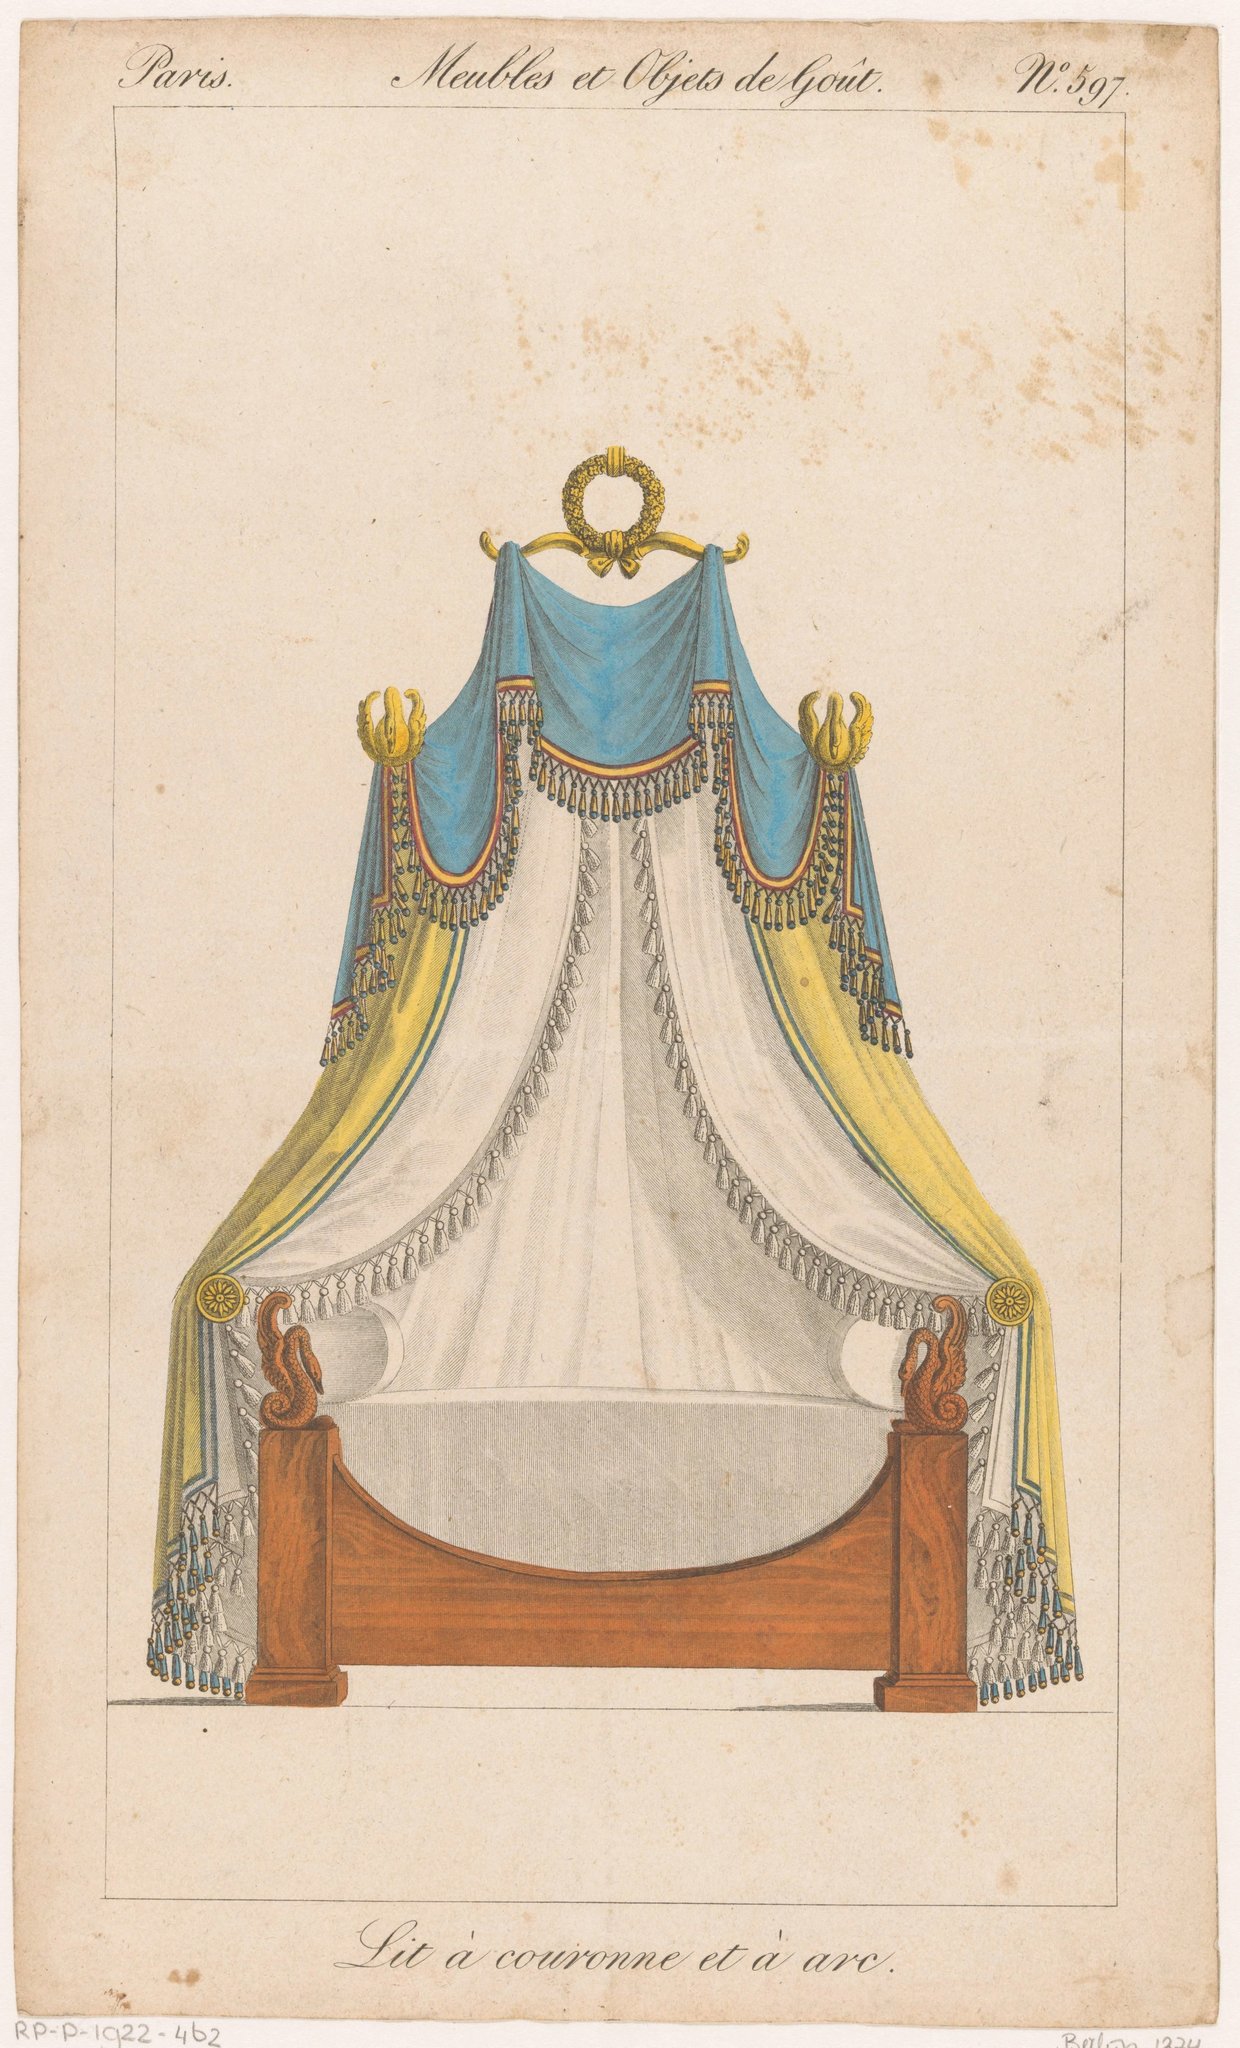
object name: print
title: Lit à couronne et à arc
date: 1801-1831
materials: paper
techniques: engraving, hand coloring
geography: paris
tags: bed with tester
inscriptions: collector's mark: Lugt 2233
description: Een ontwerp voor een hemelbed gedecoreerd met zwanen. De bekroning is gedecoreerd met een krans en twee zwanen. Prentnummer 597.